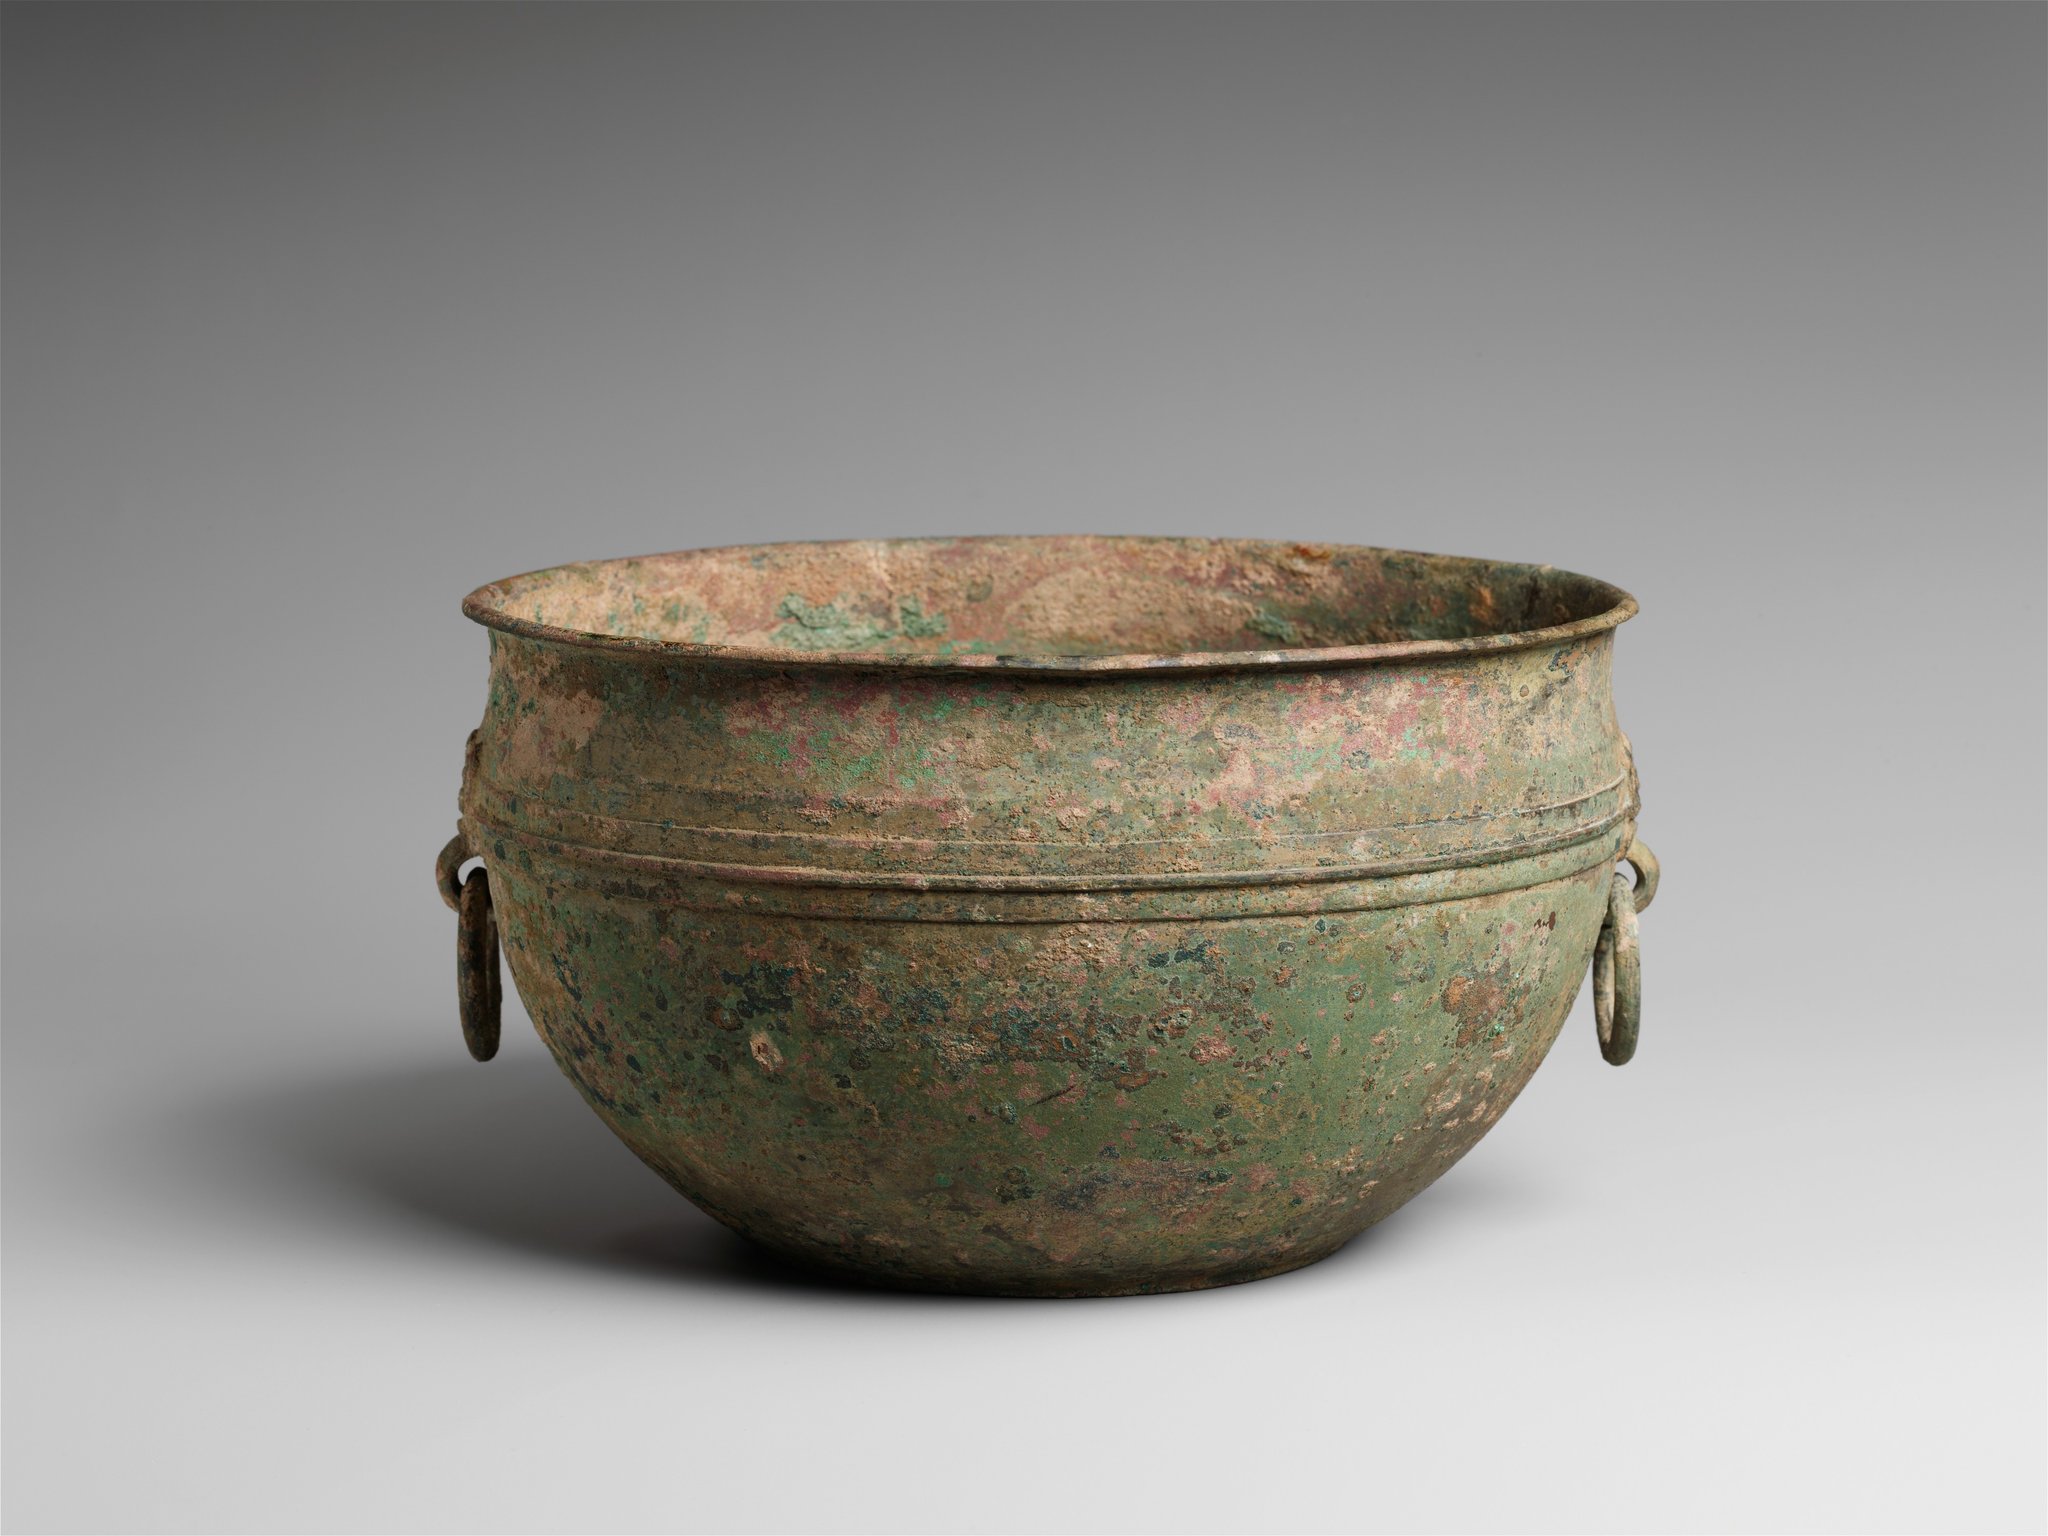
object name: vessel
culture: chinese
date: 770-256 BCE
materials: bronze